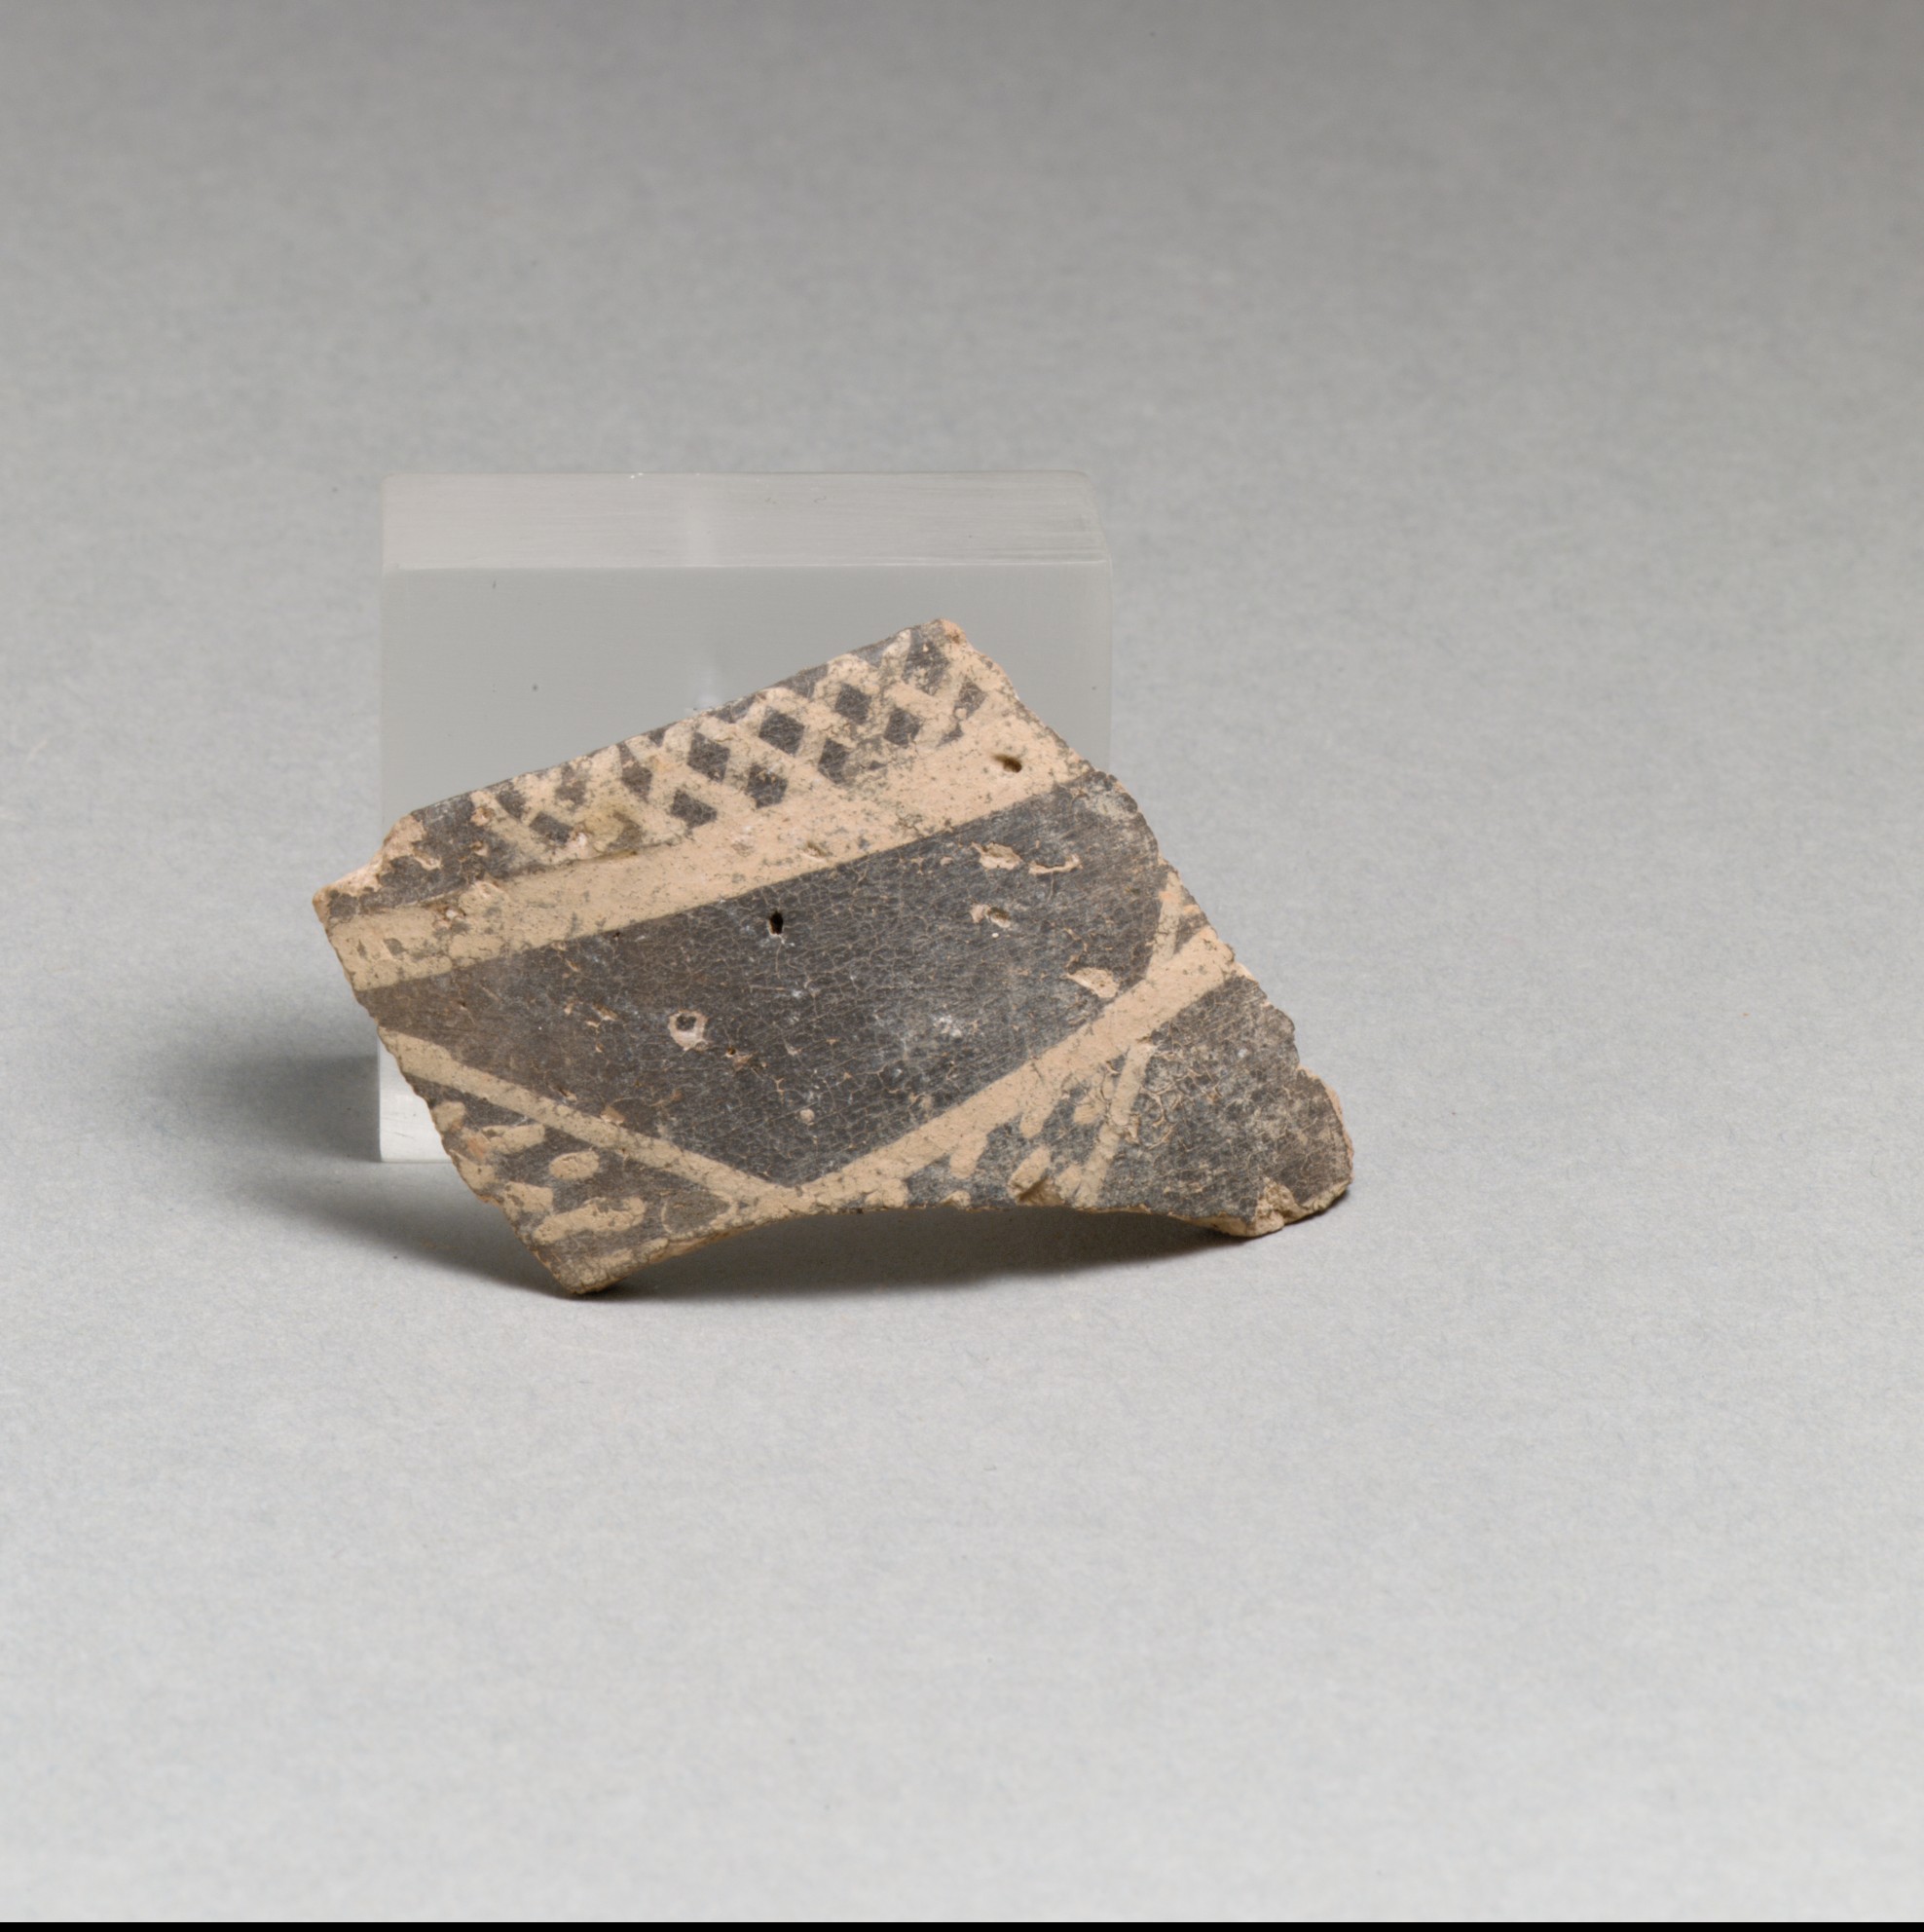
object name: vase fragment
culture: minoan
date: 2600-2000 BCE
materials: terracotta